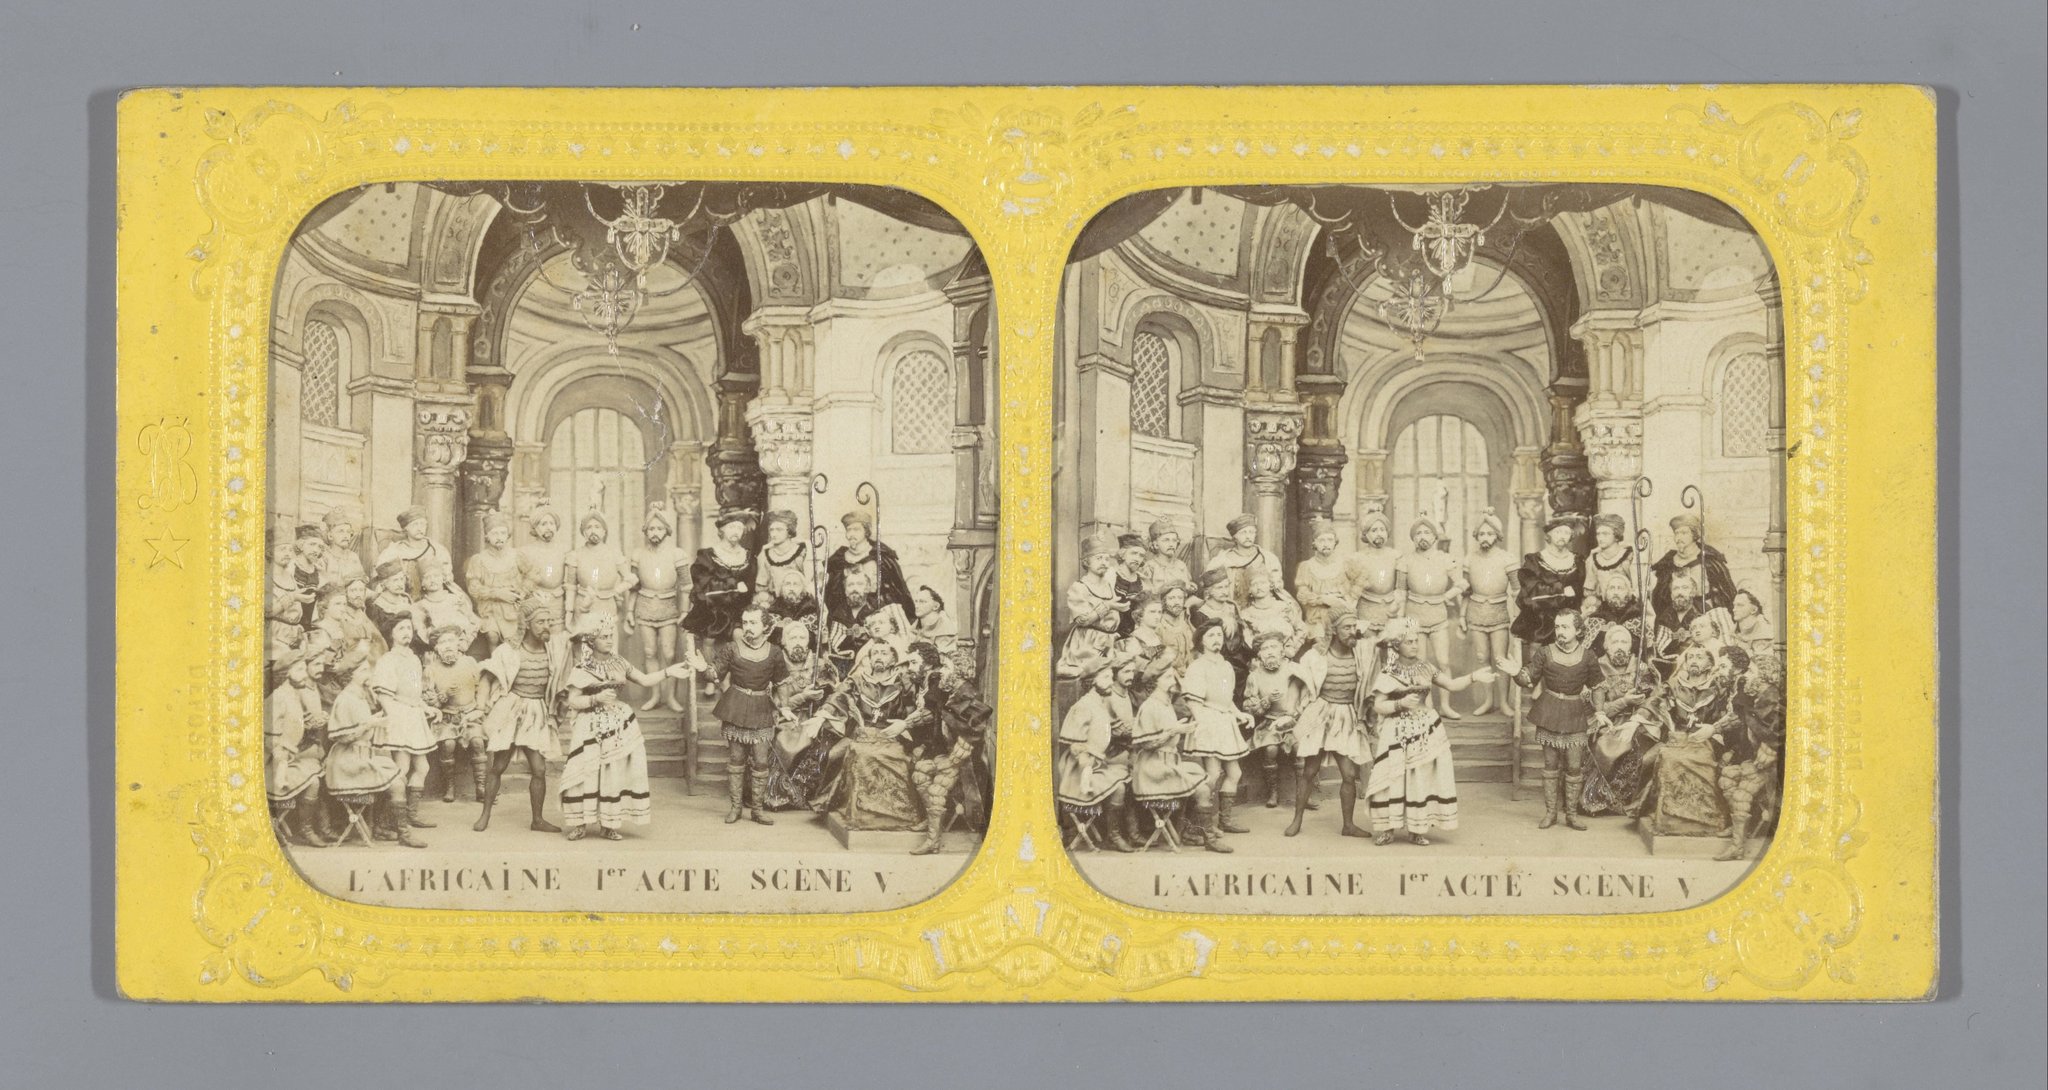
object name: tissue stereograph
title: L'Africaine 1er acte, scène V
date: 1873-1874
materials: cardboard, paper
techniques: albumen print, cutting, hand coloring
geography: paris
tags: opera, paris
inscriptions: inscription: ‘Depose’, inscription: ‘Le dépôt de cette publication ayant été fait en France selon la loi, et à/ l'étranger conformémt aux conventions internationnales, toute reproduc-/ tion en est rigoureusemt interdite, et les épreuves non revêtues de notre/ marque de fabrique seront considérées comme contrefaçon. - B et D éditrs’, inscription: ‘JJ Henny 21.’